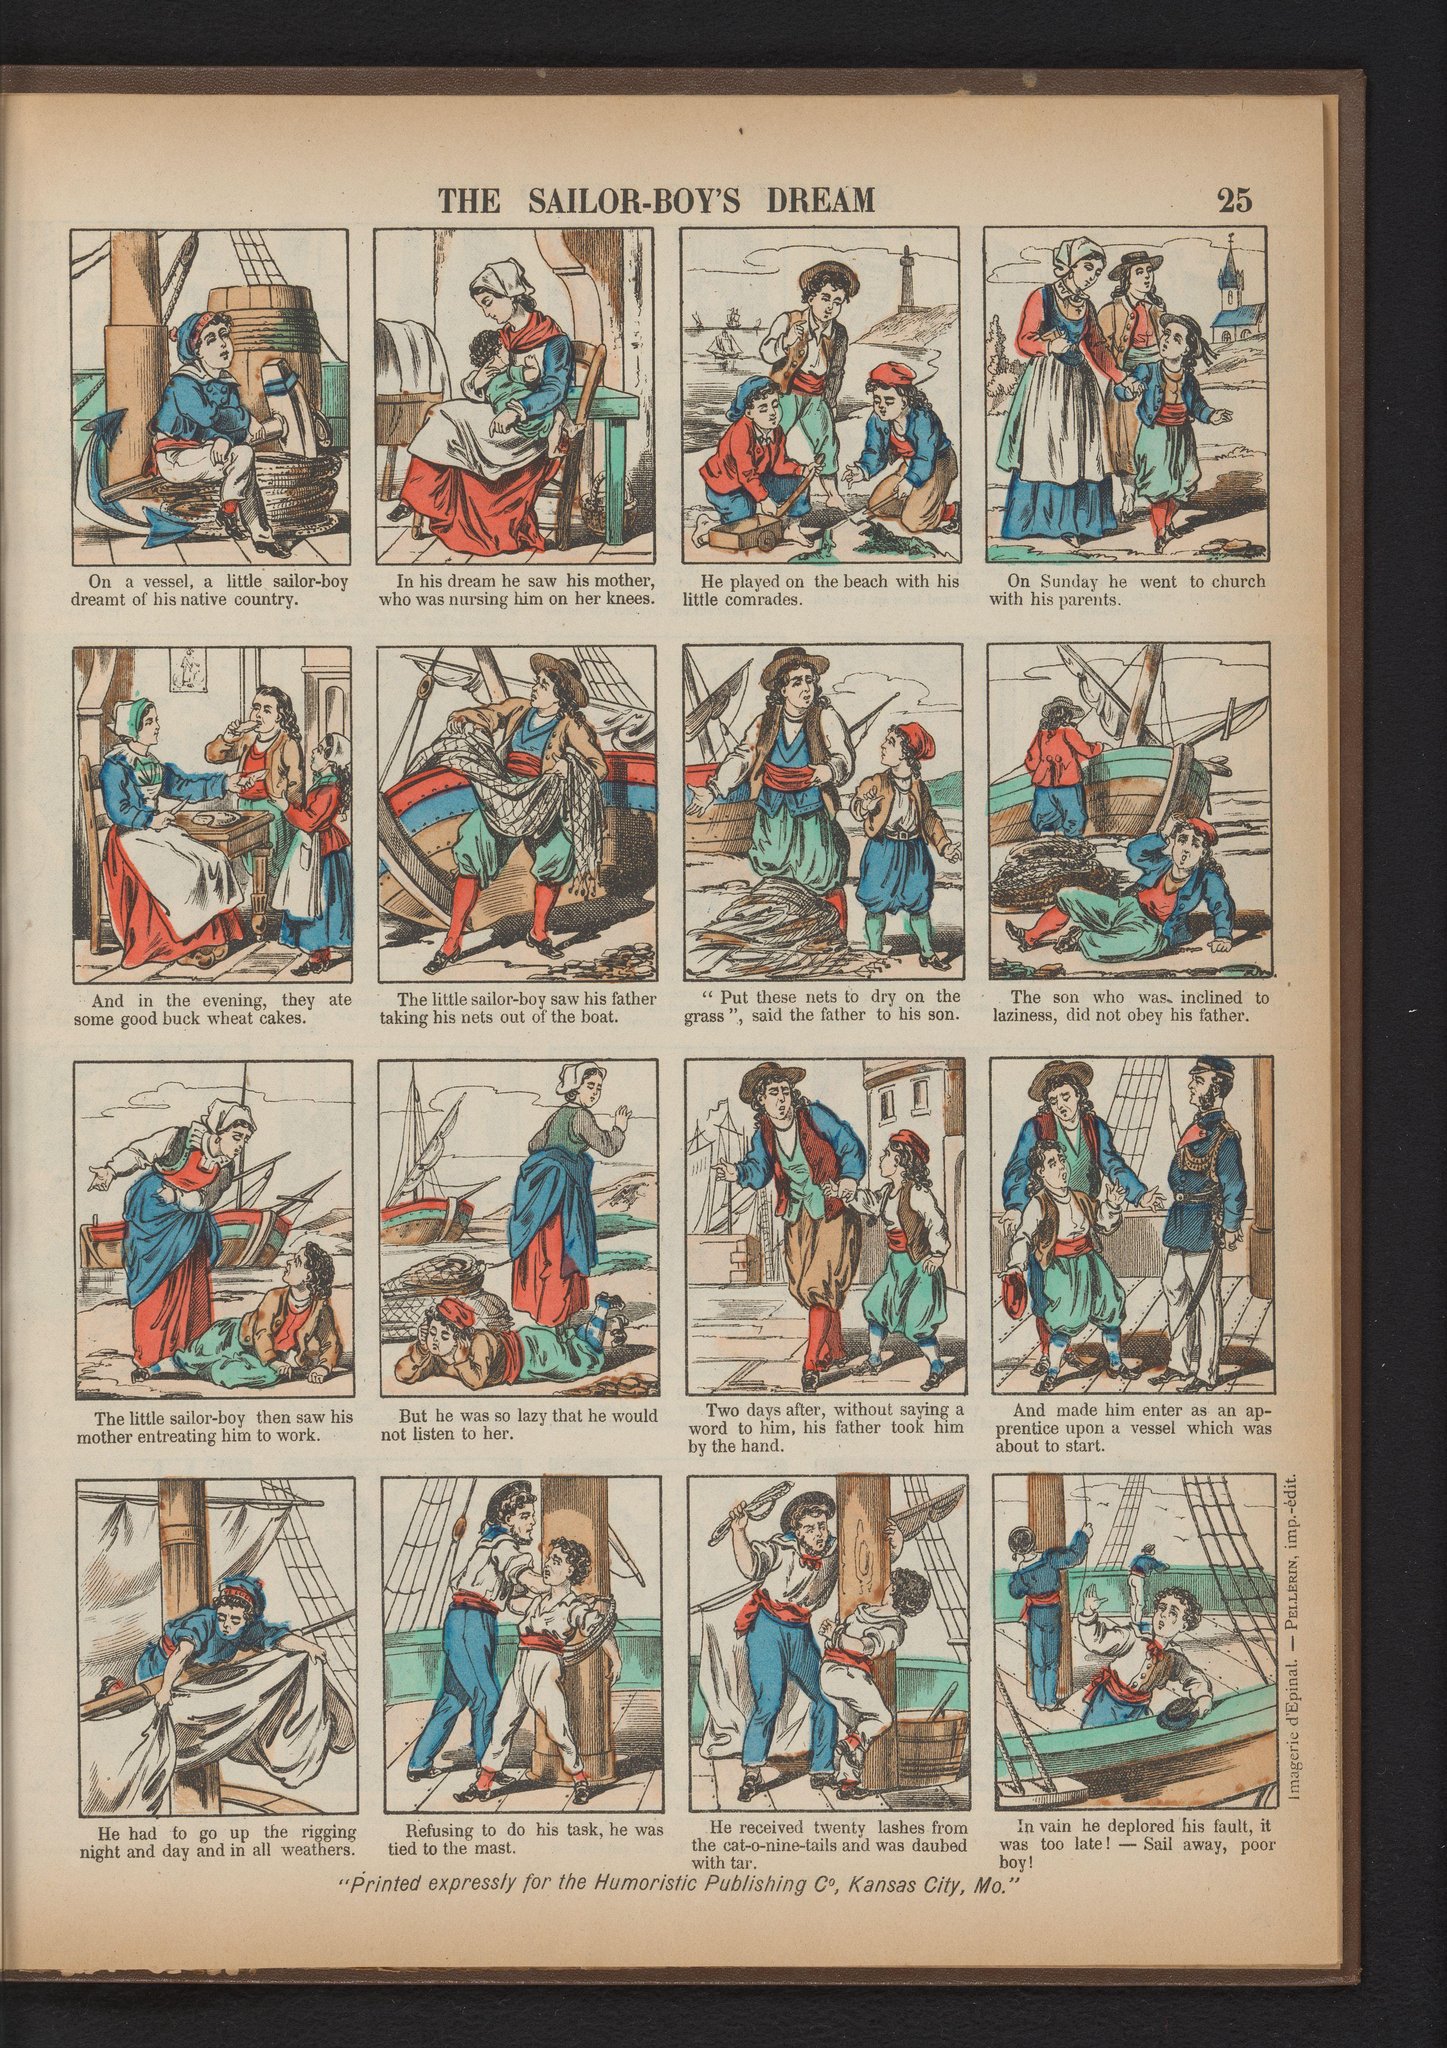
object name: popular print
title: The sailor-boy's dream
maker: Anonymous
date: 1893-1894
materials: paper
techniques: colour, letterpress printing, lithograph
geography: epinal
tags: sailor, dream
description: Blad met zestien voorstellingen over de droom van een jonge matroos. Onder elke voorstelling een onderschrift in het Engels. Deze prent maakt deel uit van een album.